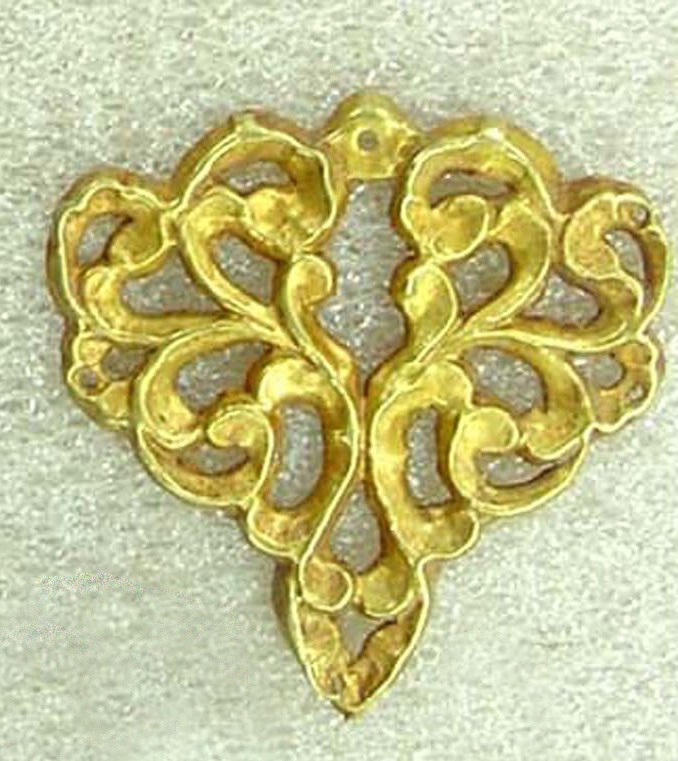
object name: plaque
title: Triangular Plaque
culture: northwest chinese or eastern central asian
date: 634-900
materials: gold